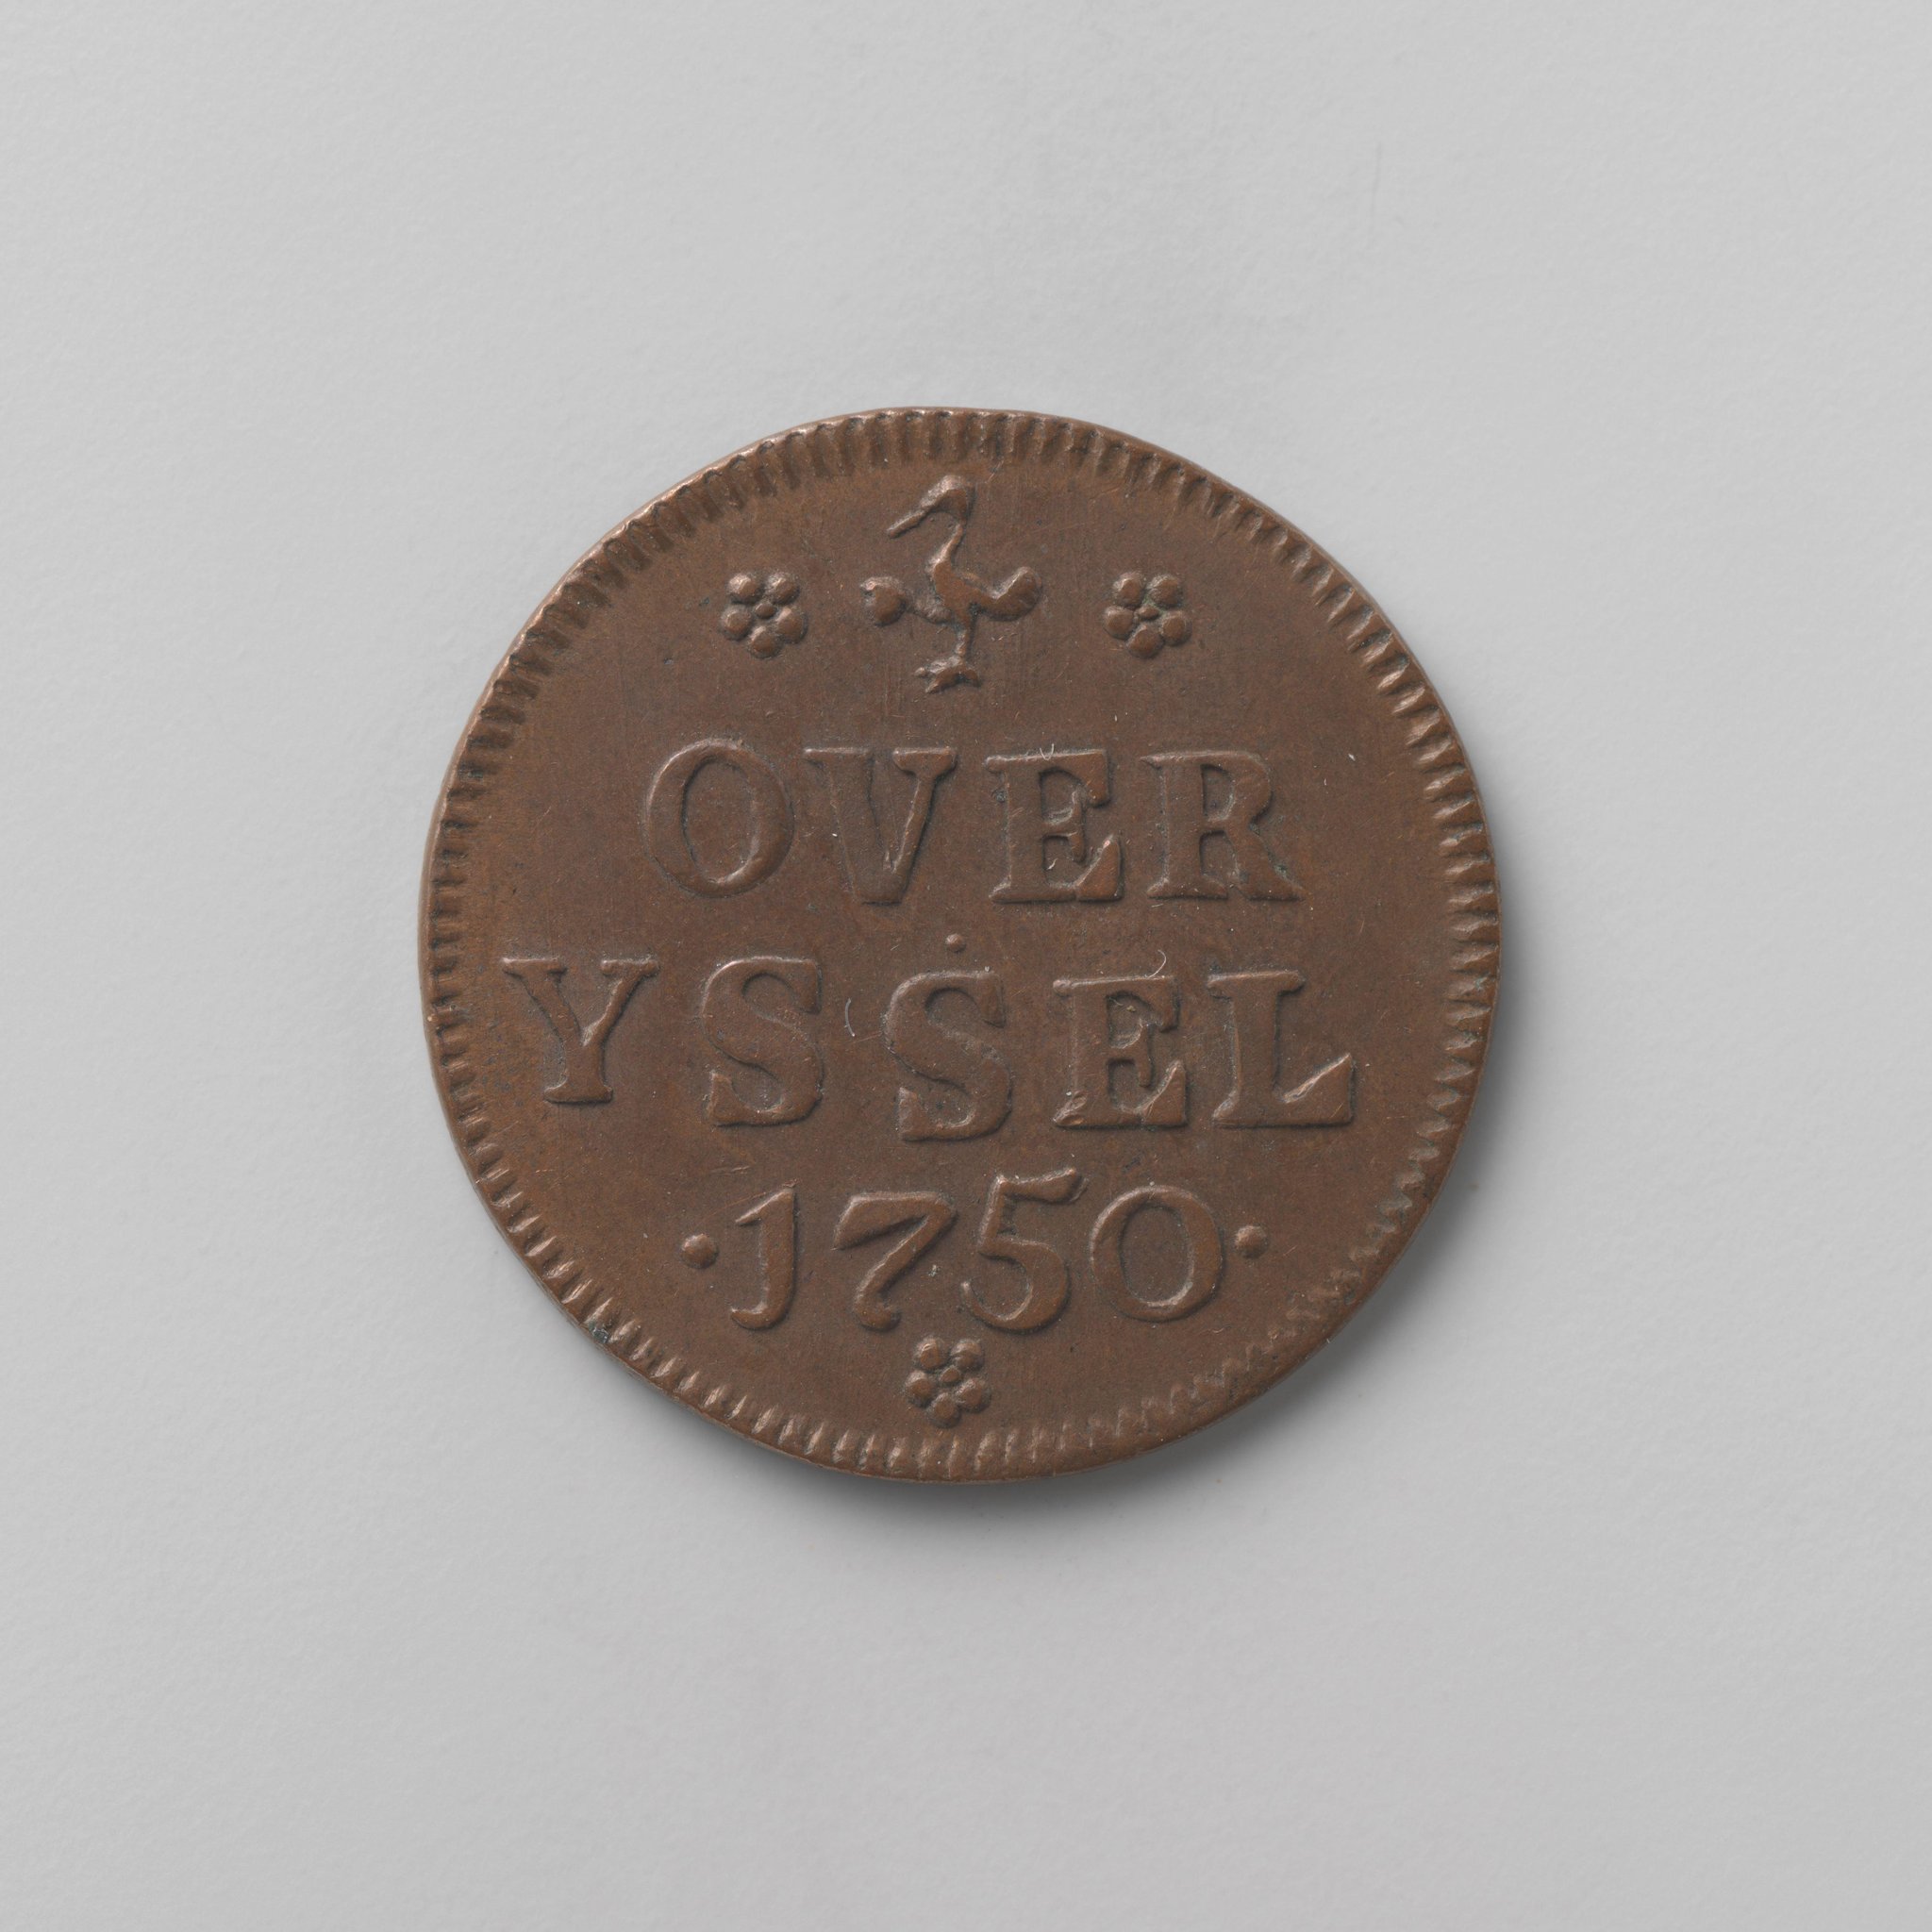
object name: coin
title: Overijsselse duit, 1750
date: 1750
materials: copper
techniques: striking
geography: kampen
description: Koperen munt. Voorzijde: tussen wapenspreuk gekroond provinciaal wapenschild. Keerzijde: tweeregelig opschrift, waarboven muntmeesterteken en waaronder jaartal.